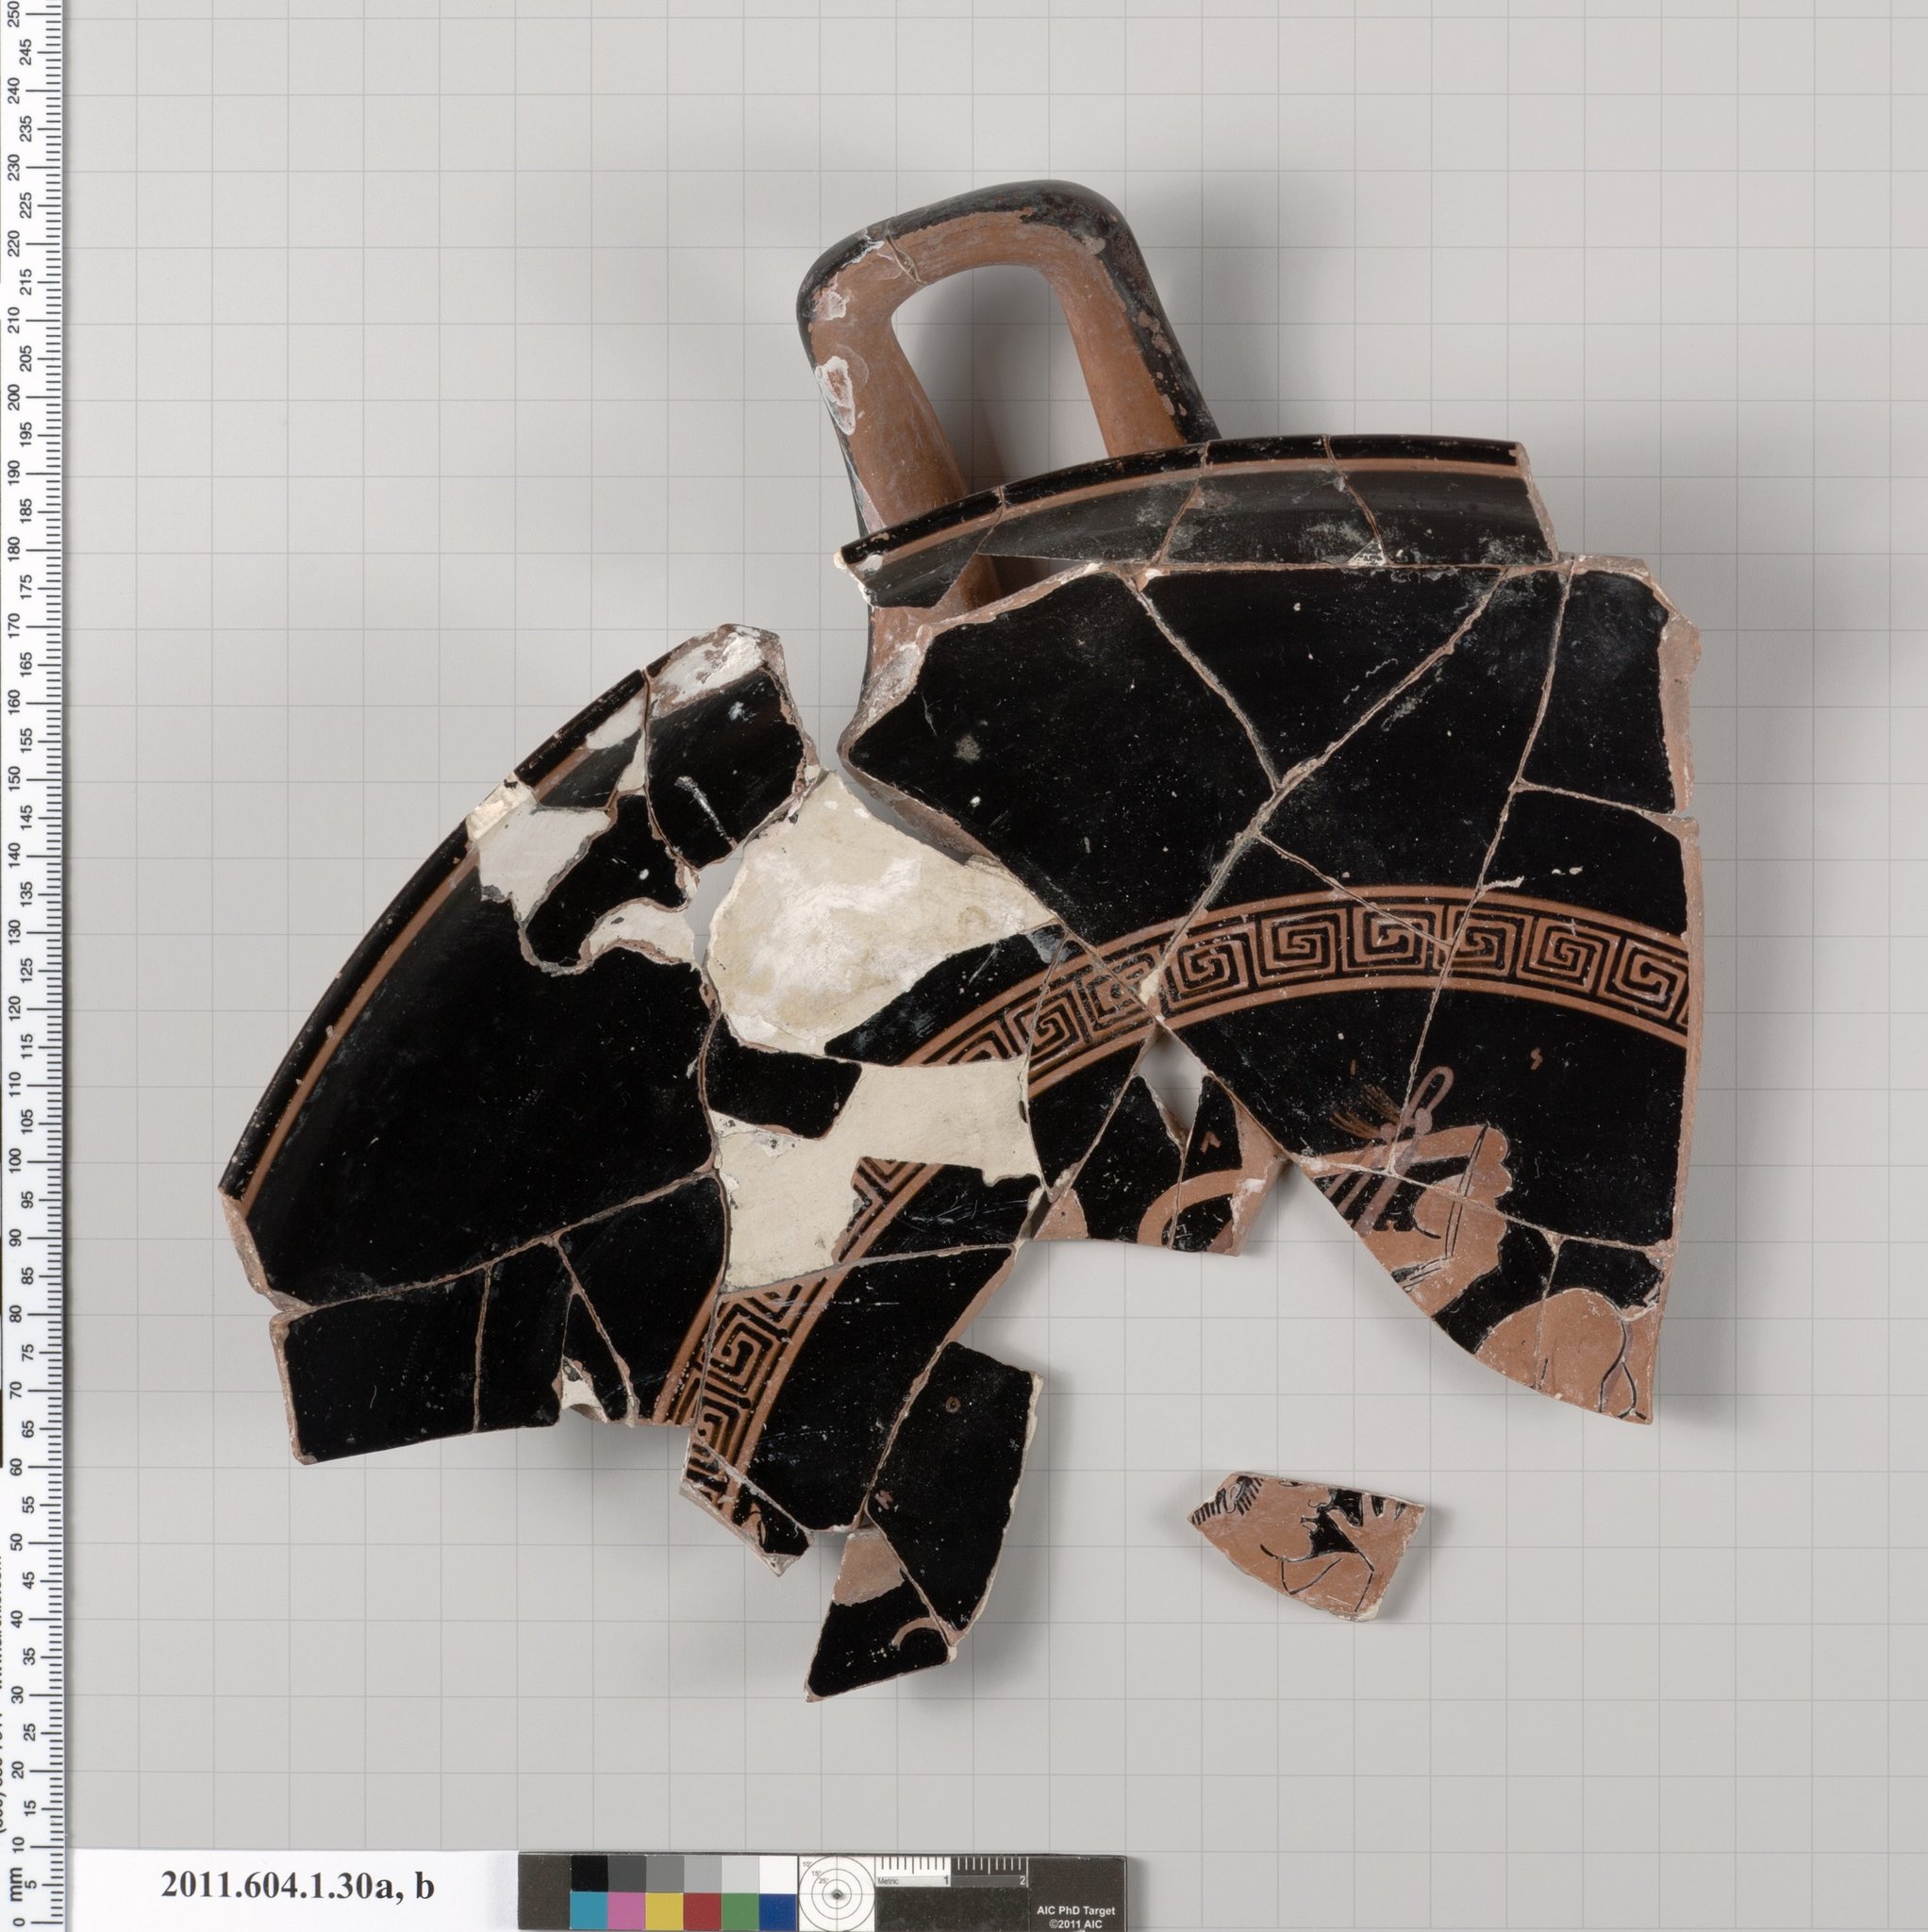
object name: kylix fragment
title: Terracotta fragments of a kylix (drinking cup)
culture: greek, attic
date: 490-480 BCE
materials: terracotta